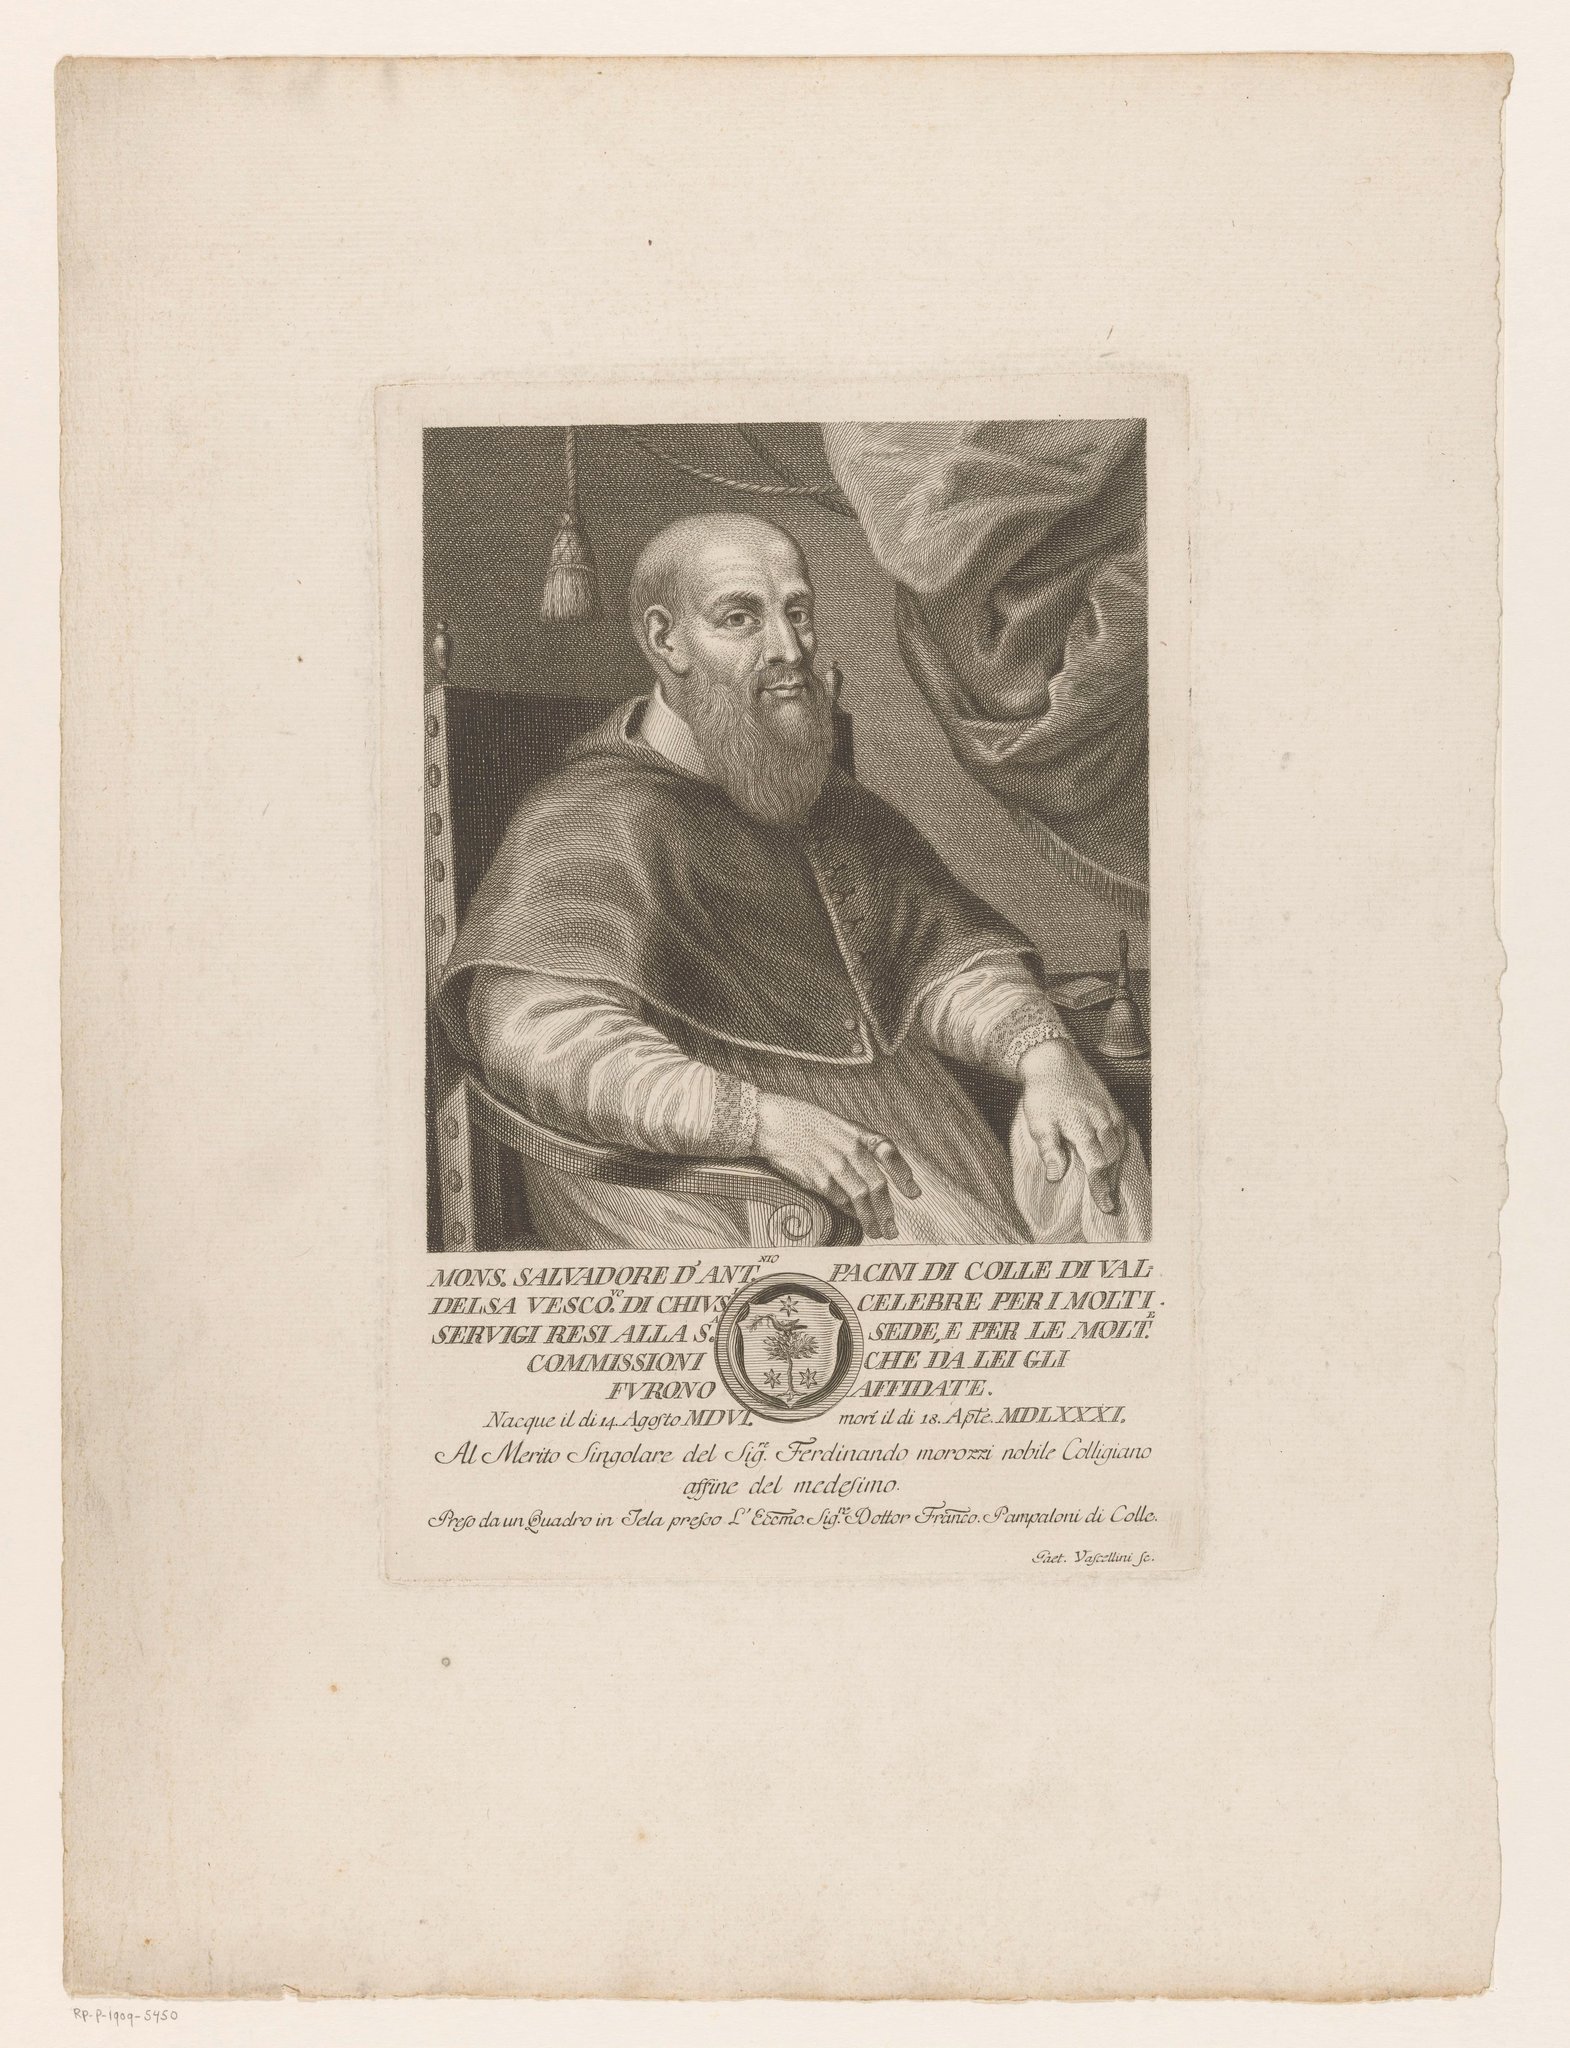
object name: print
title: Portret van bisschop Salvatore Pacini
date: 1755-1805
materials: paper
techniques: engraving, etching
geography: italy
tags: archbishop, bishop, etc. (roman catholic), historical persons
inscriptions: collector's mark: Lugt 2228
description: Onder het portret een tekst in het Italiaans en een wapenschild in een cirkelvormig kader.